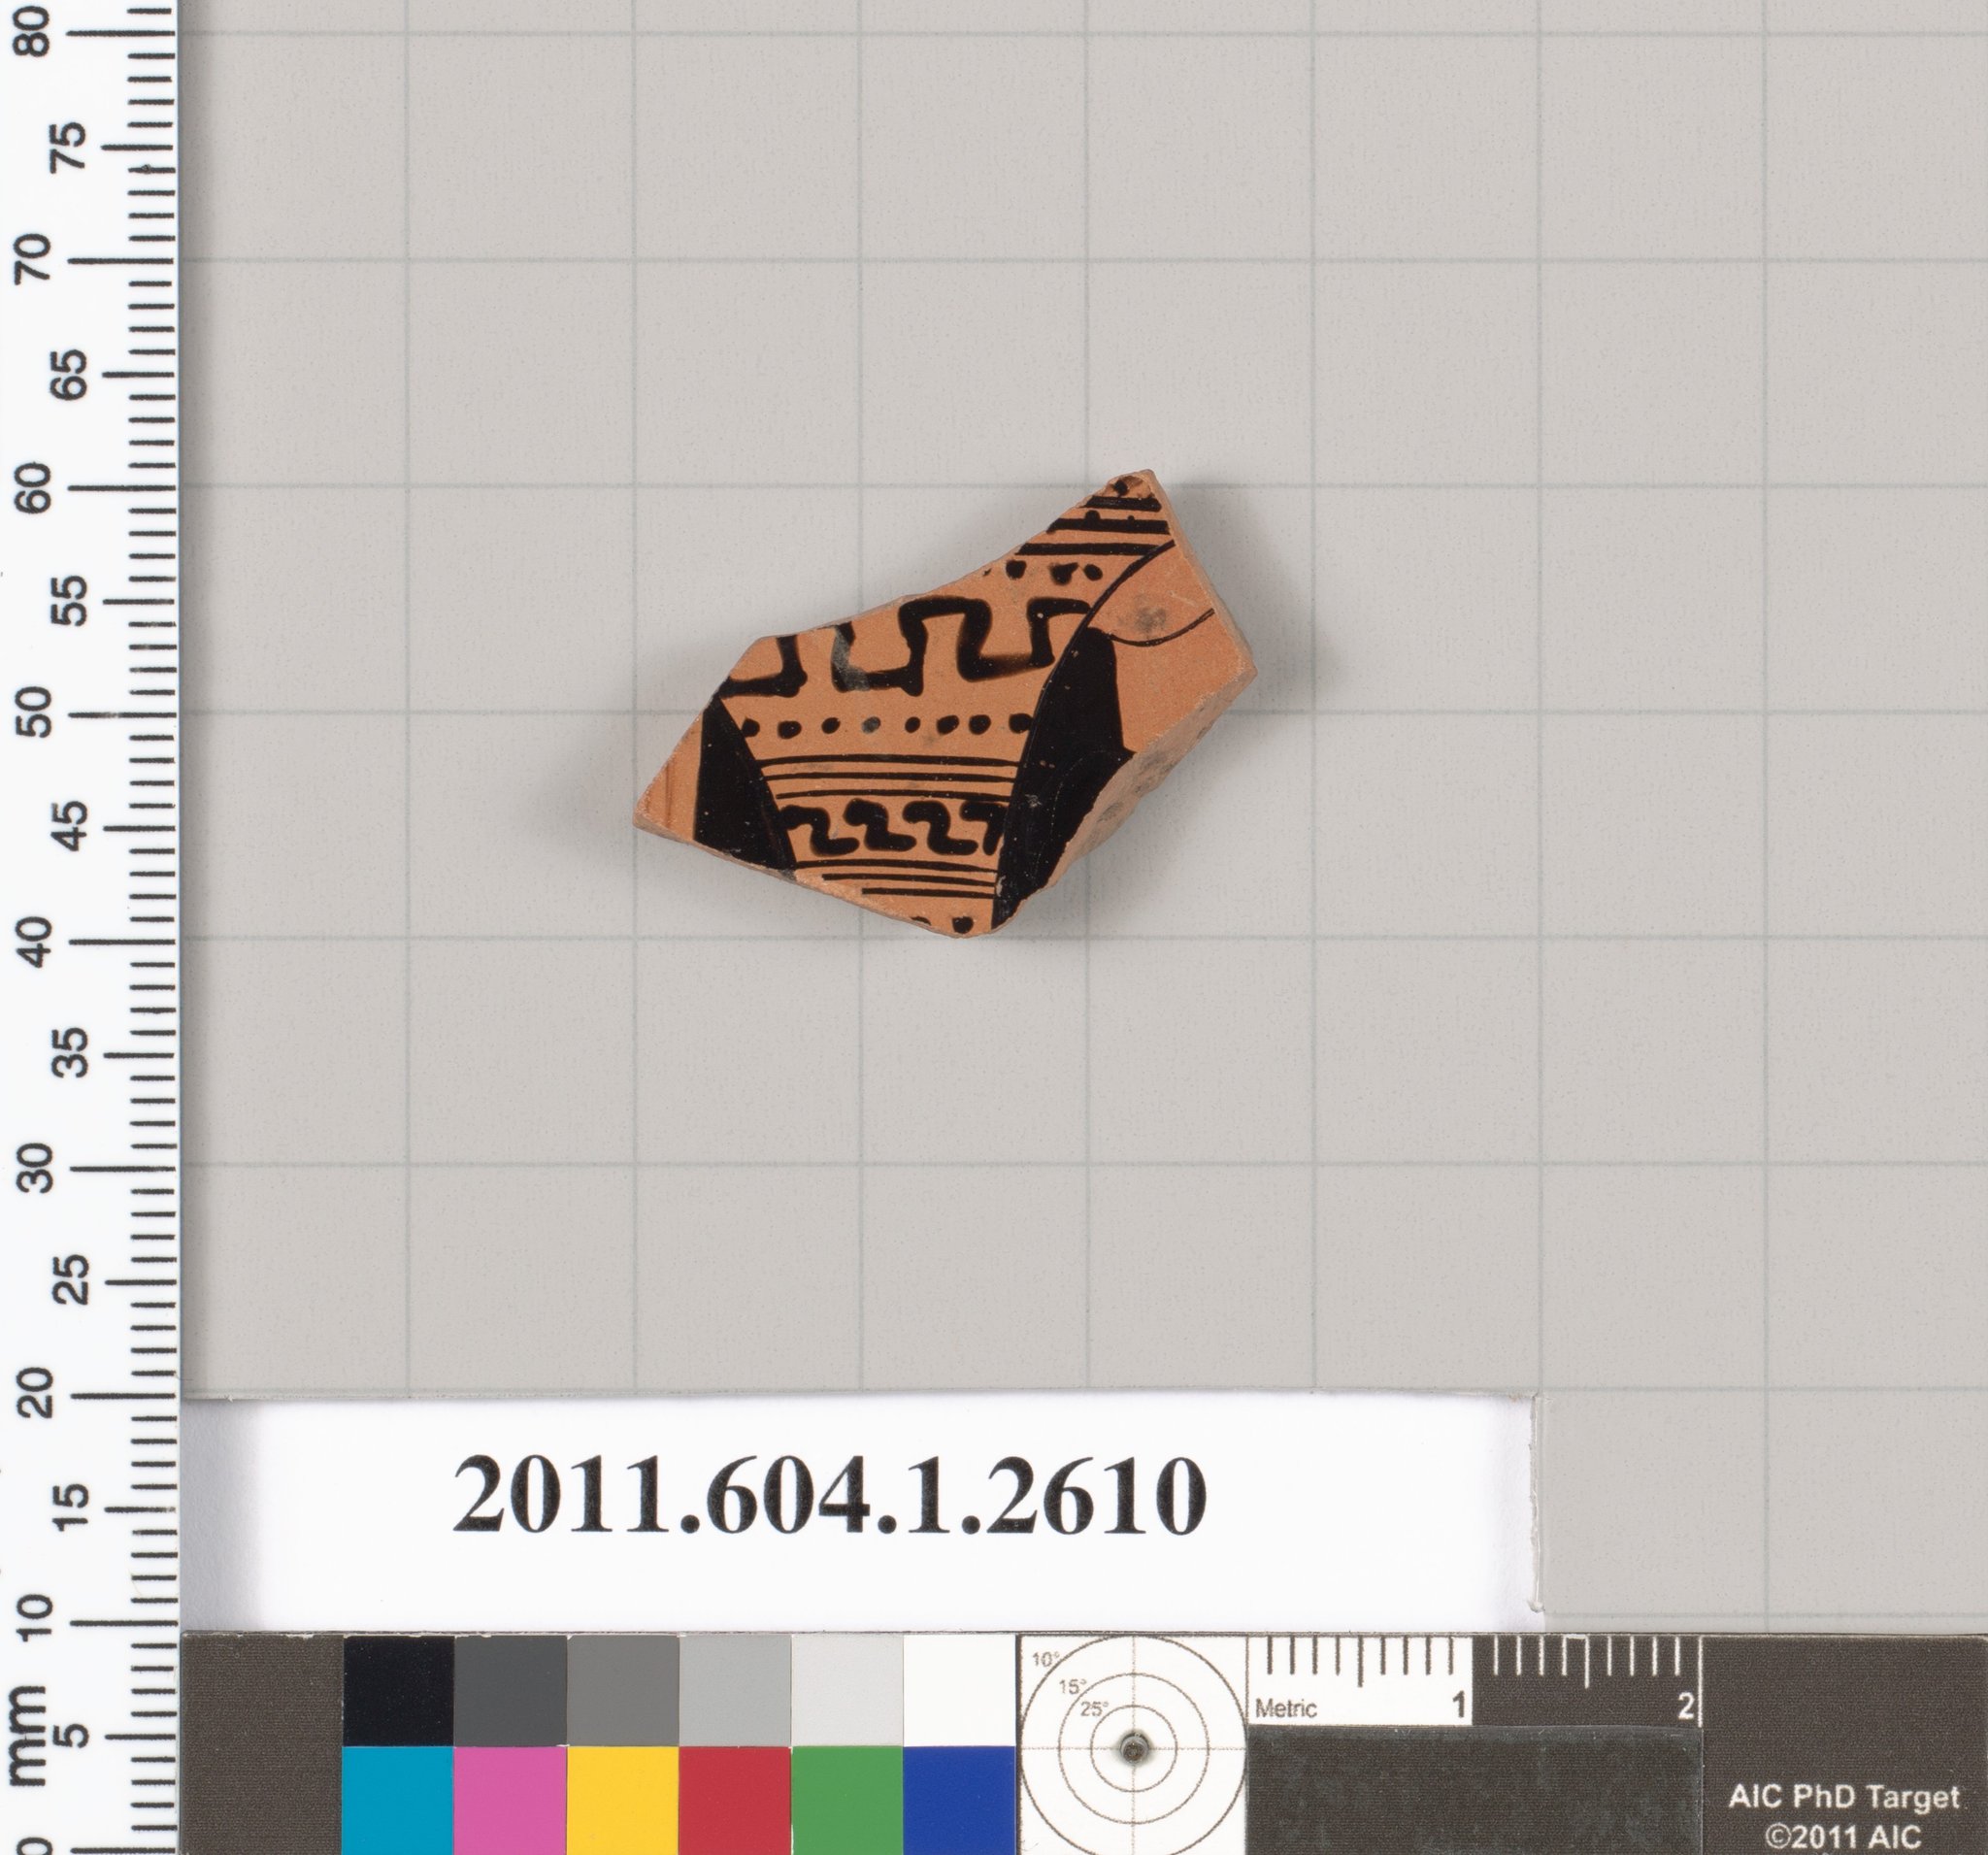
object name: kylix fragment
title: Terracotta fragment of a kylix (drinking cup)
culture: greek, attic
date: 500-480 BCE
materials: terracotta